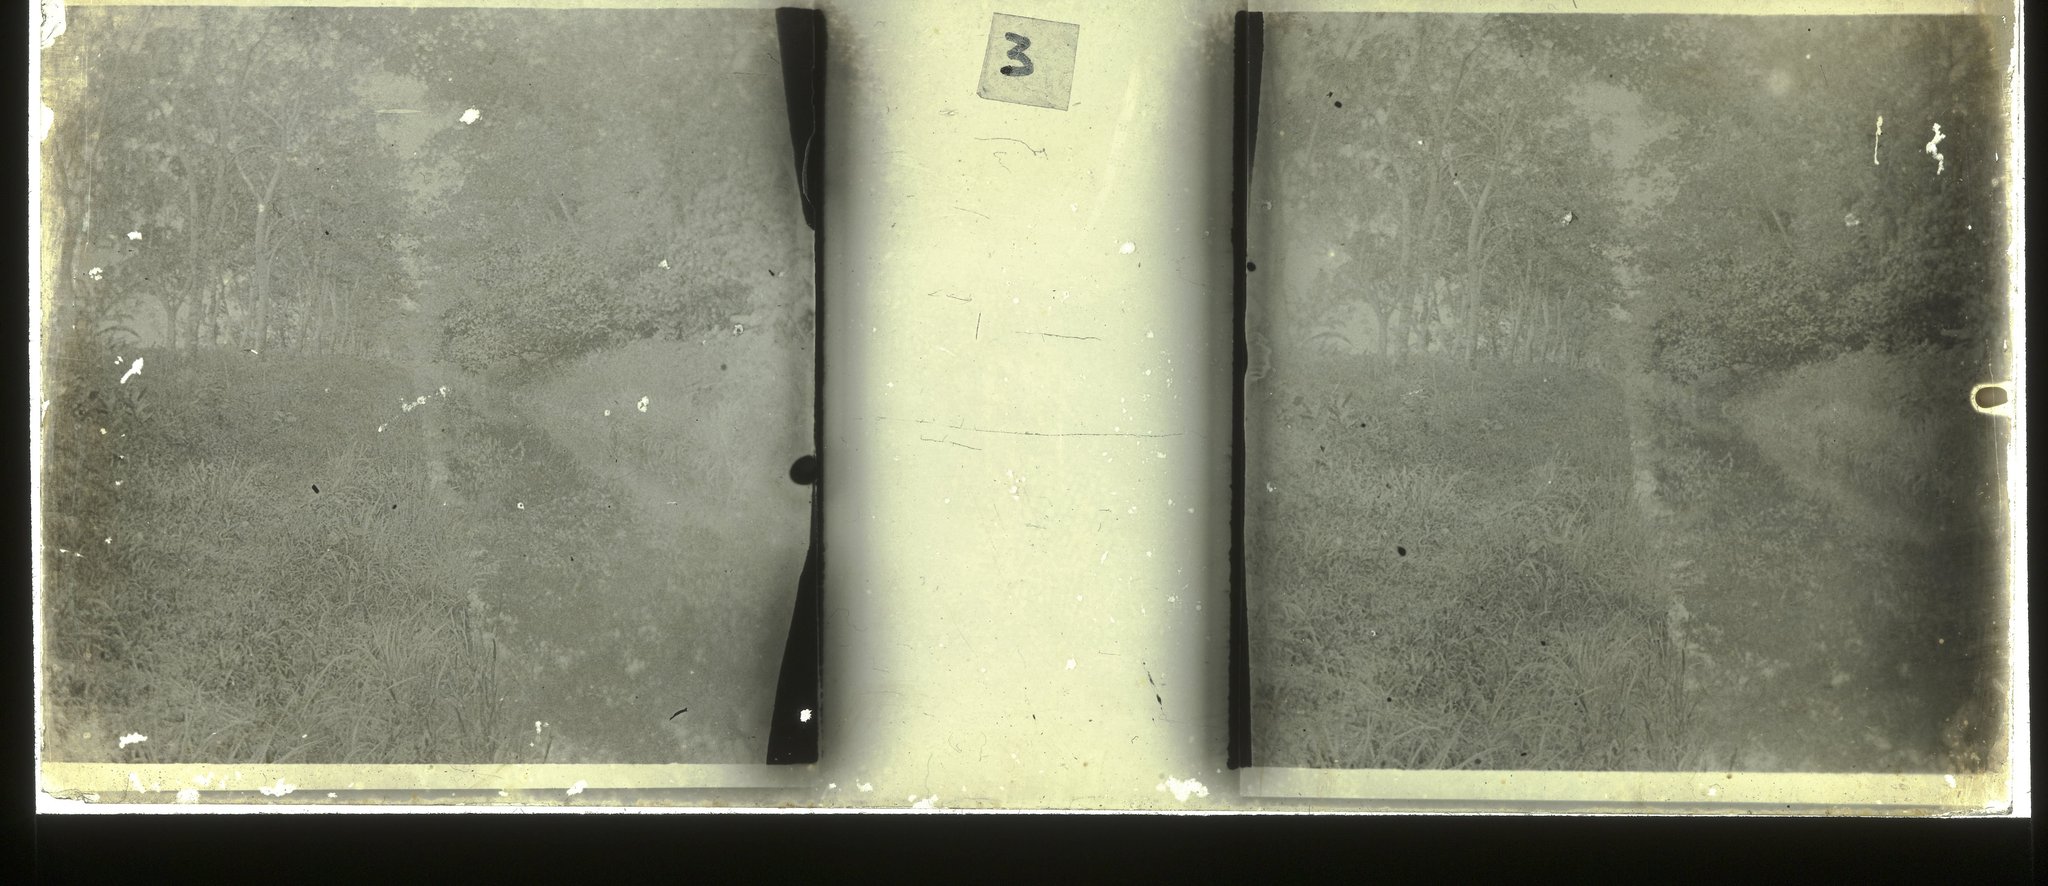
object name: stereograph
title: Nederlands landschap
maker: theodoor brouwers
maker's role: amateurfotograaf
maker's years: 1874-1932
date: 1913-1930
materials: glass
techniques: photography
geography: netherlands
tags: amsterdam, theodoor brouwers, netherlands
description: In de periode 1911-1932 woonde op plantage Accaribo in Suriname de familie Brouwers van wie de foto's afkomstig zijn. Rond 1910 vond Theodoor Brouwers werk op plantage Accaribo. In 1929 werd hij eigenaar van de plantage. Op Accaribo werden in zijn tijd bananen geproduceerd en wat koffie.